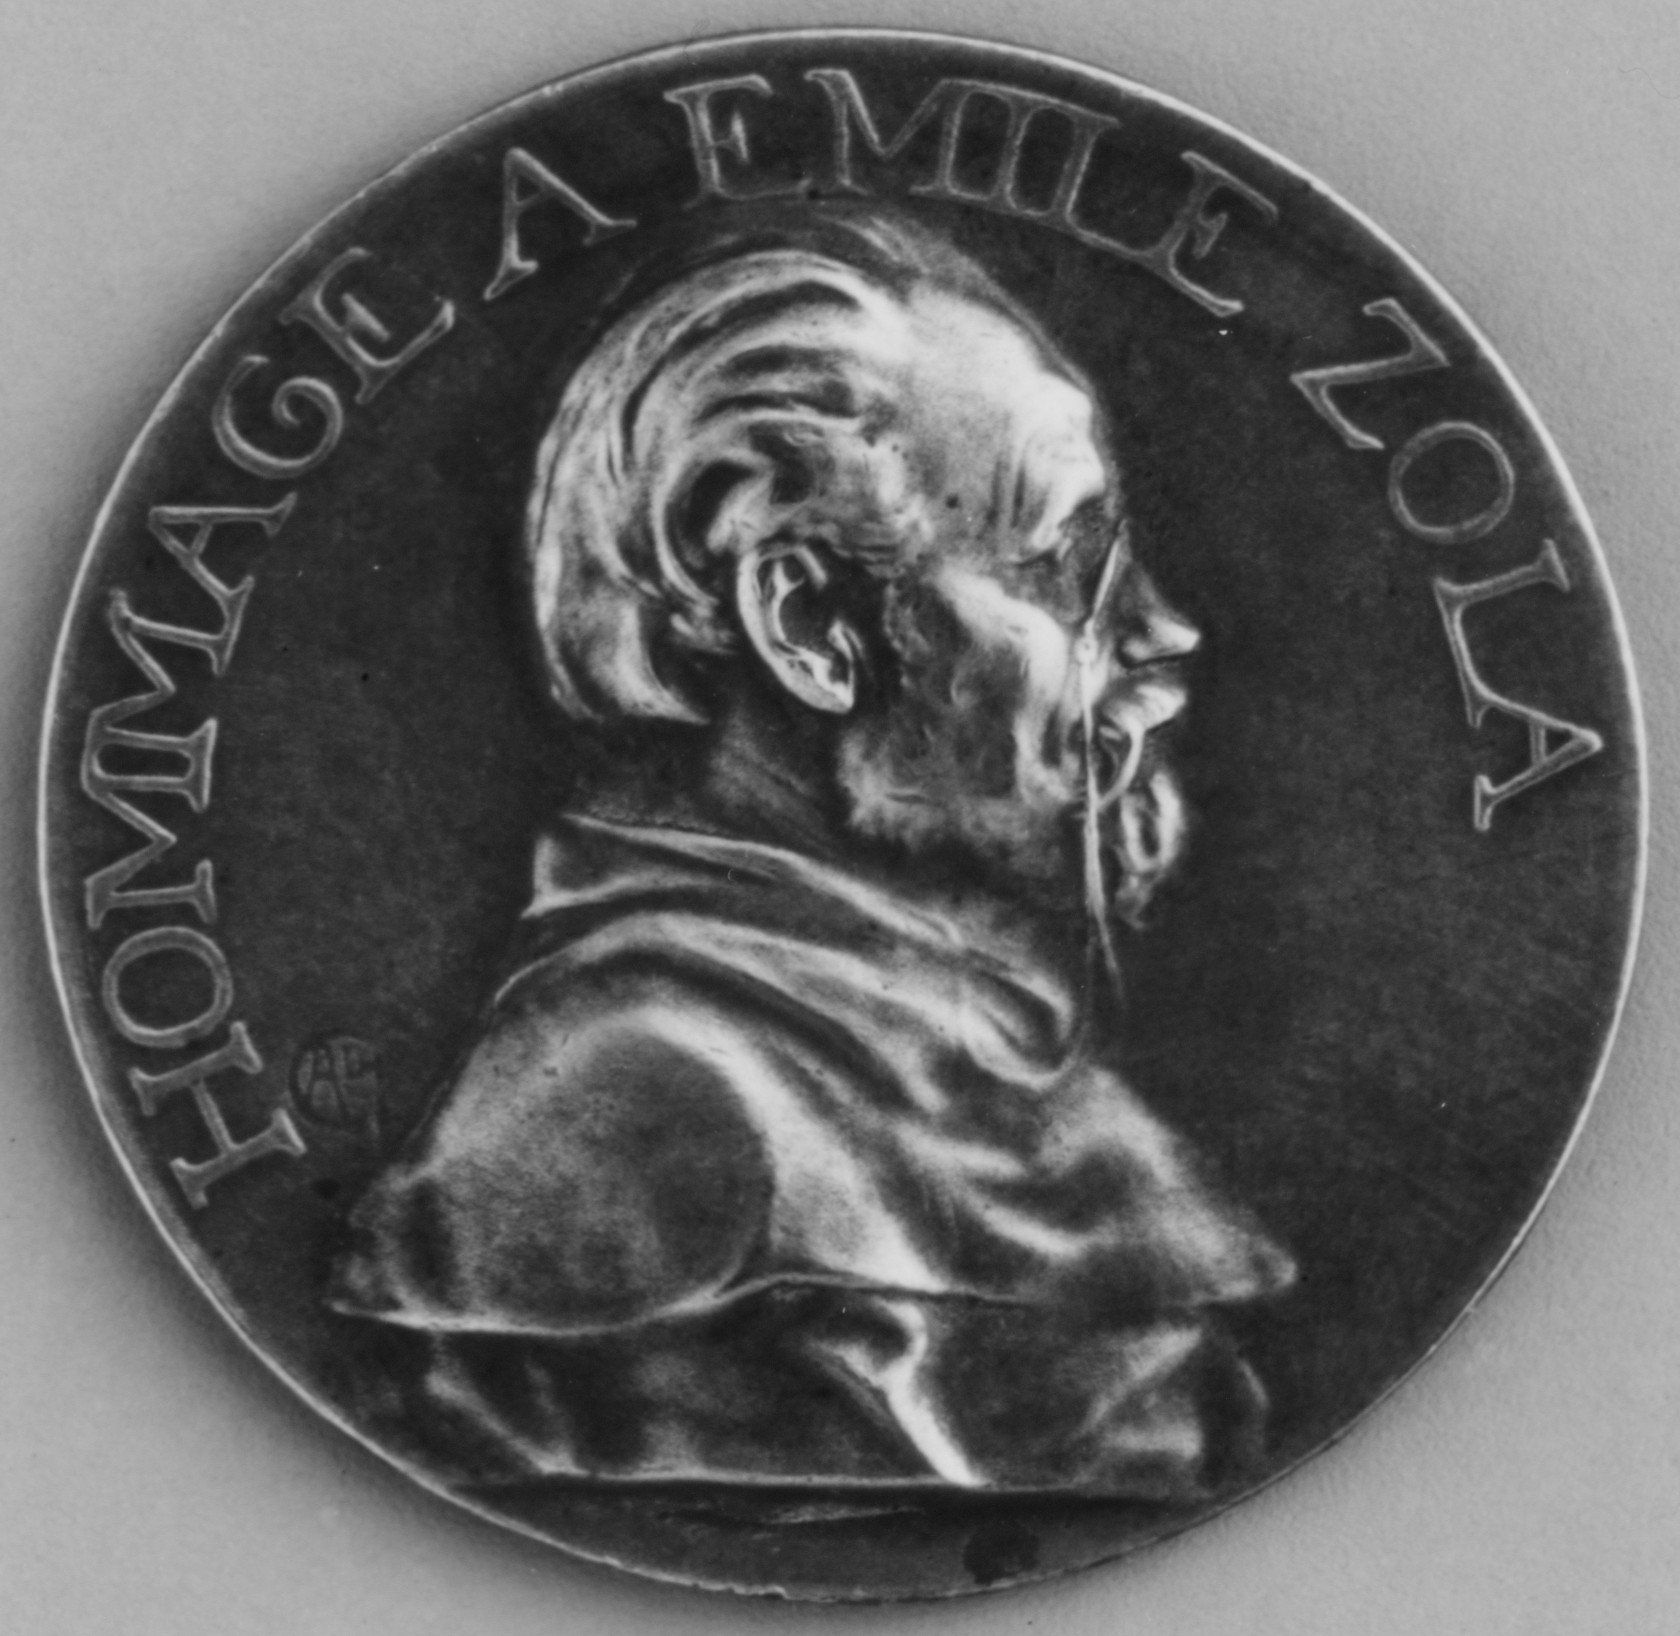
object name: medal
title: Émile Zola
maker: alexandre-louis-marie charpentier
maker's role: artist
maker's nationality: french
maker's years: 1856-1909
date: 1898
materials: bronze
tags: men,profiles